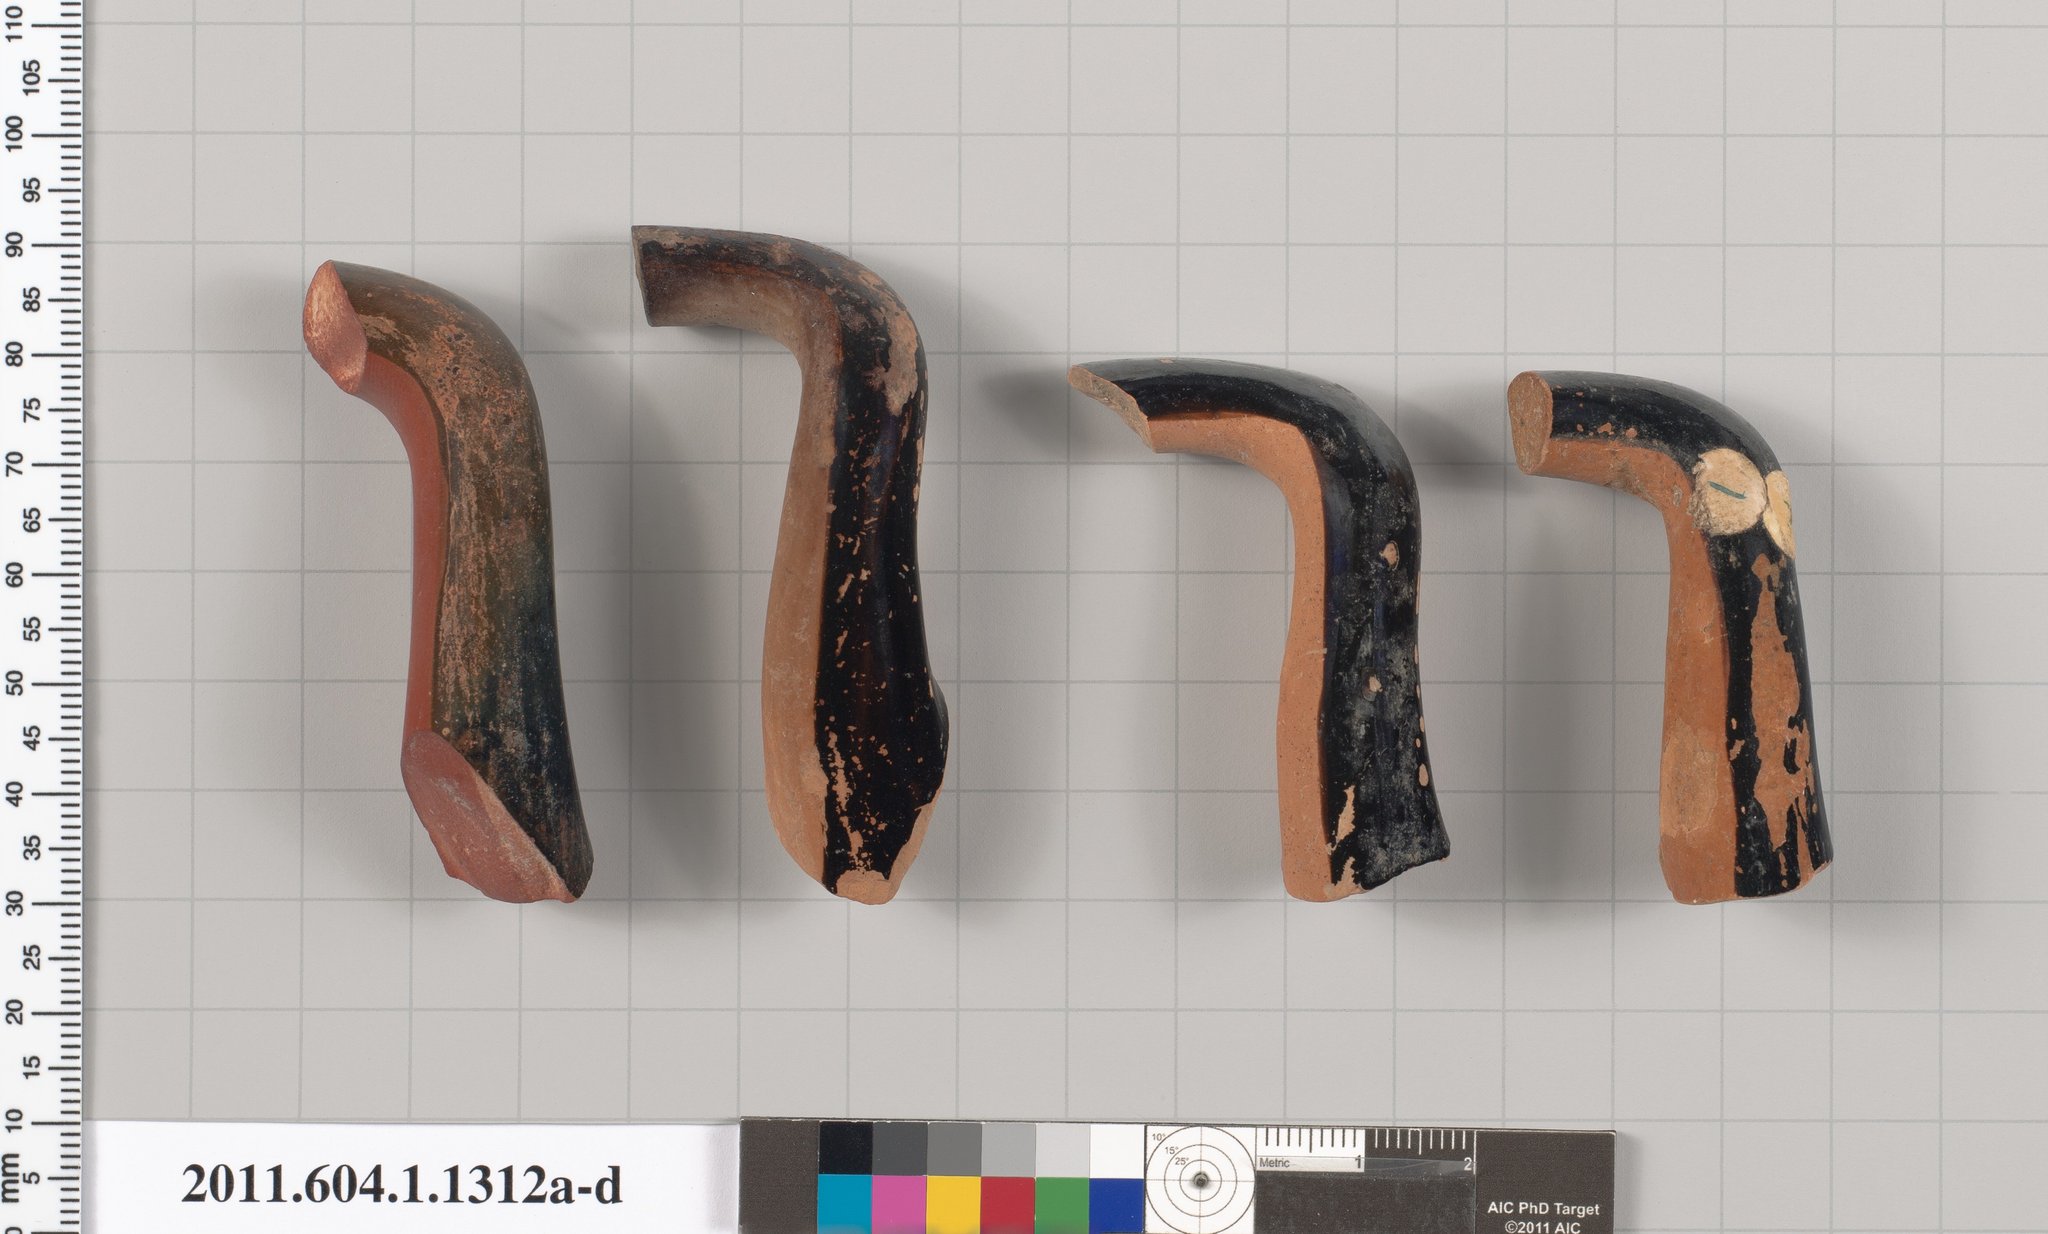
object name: kylix fragment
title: Terracotta fragments of kylikes (drinking cups)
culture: greek, attic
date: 500-401 BCE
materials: terracotta